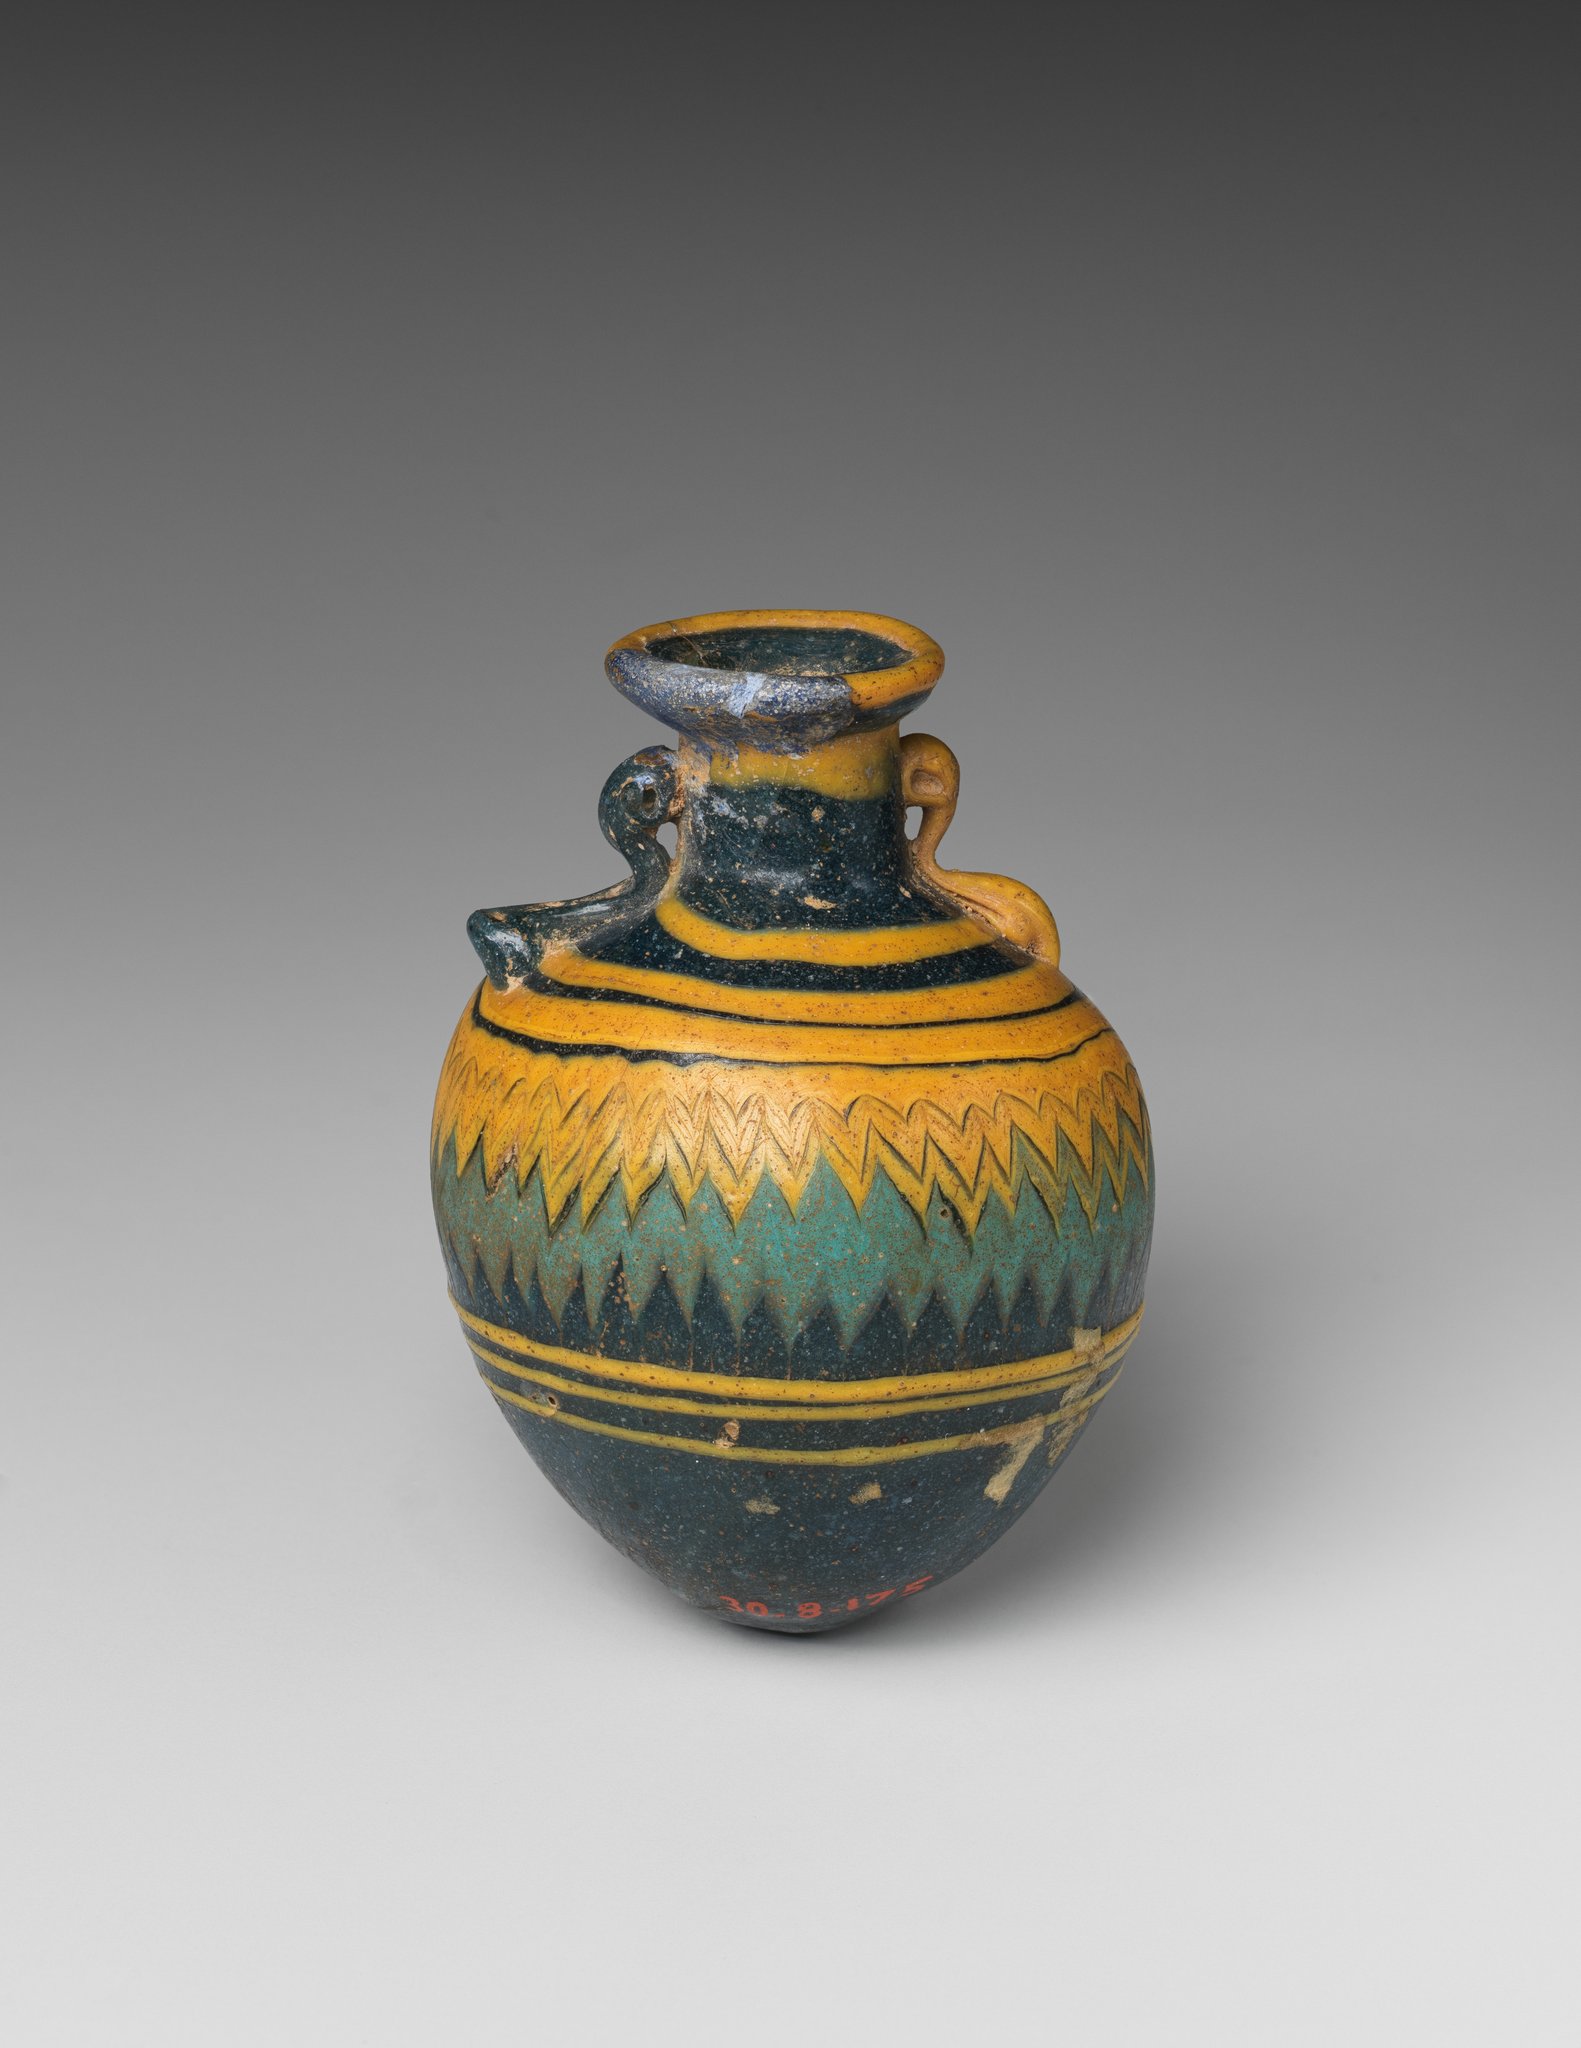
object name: vase, ariballos, polychrome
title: Perfume vase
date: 664-332 BCE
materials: glass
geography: egypt